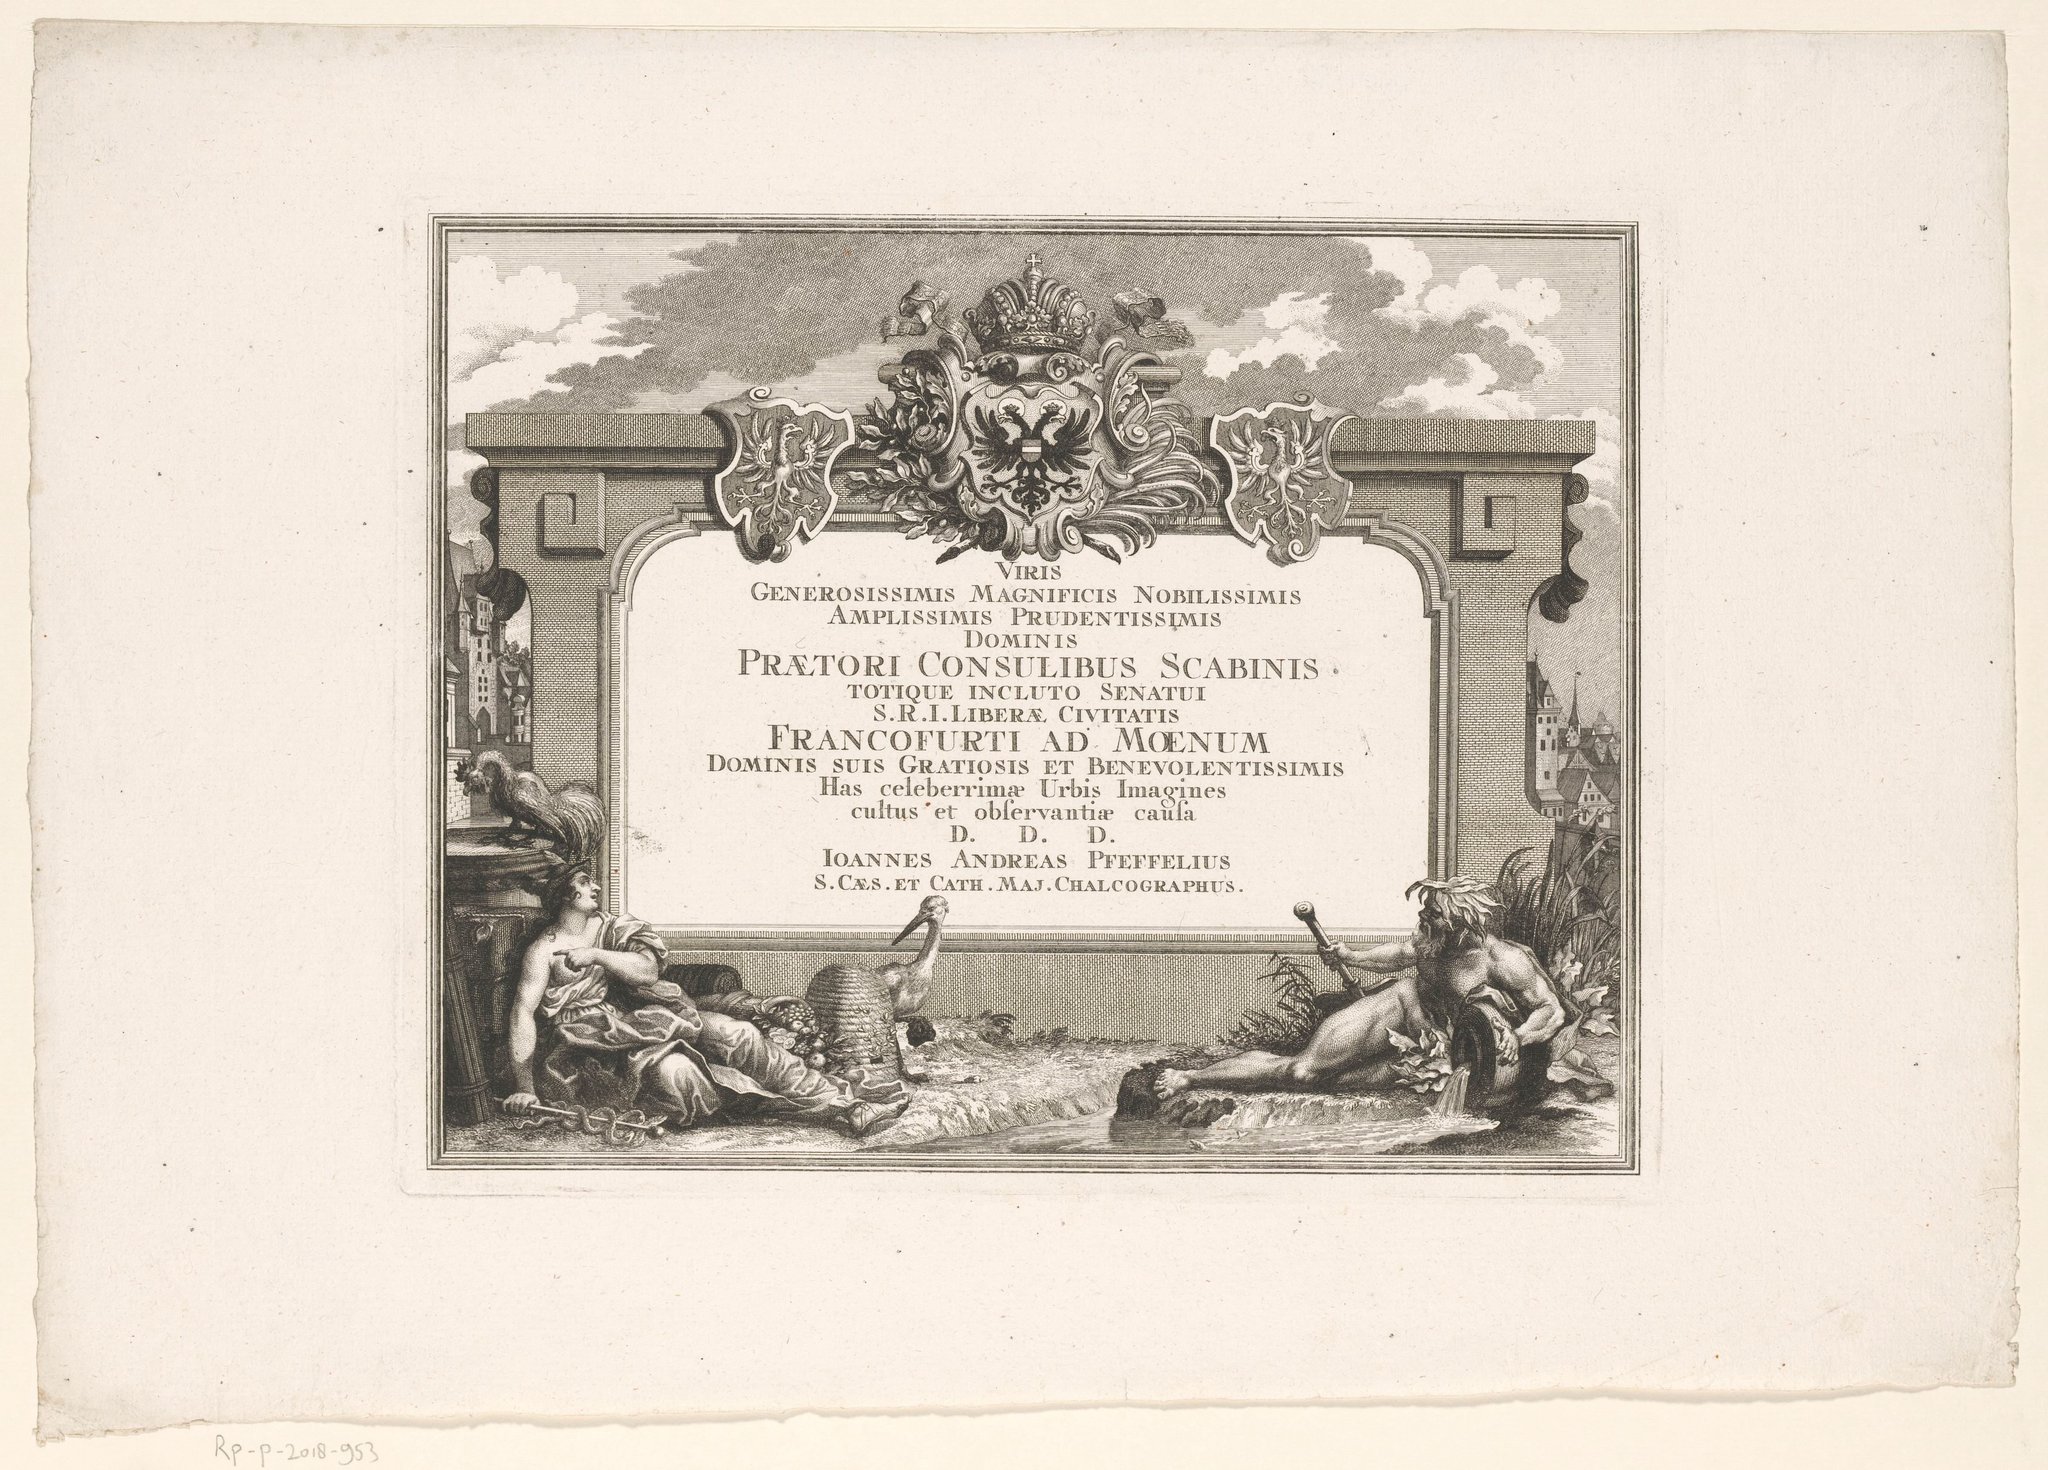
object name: print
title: Viris generosissimis magnificus nobilissimis amplissimis (...)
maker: johann andreas pfeffel (der ältere)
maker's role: print maker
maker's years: 1674-1748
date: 1738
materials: paper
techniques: engraving, etching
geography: augsburg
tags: coat of arms (as symbol of the state, etc.) (+ city; municipal), (story of) mercury (hermes), river-gods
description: Prent gebruikt in: Francofurtum ad Moenum Floridum (...). Augsburg: Johann Andreas Pfeffel, 1738.